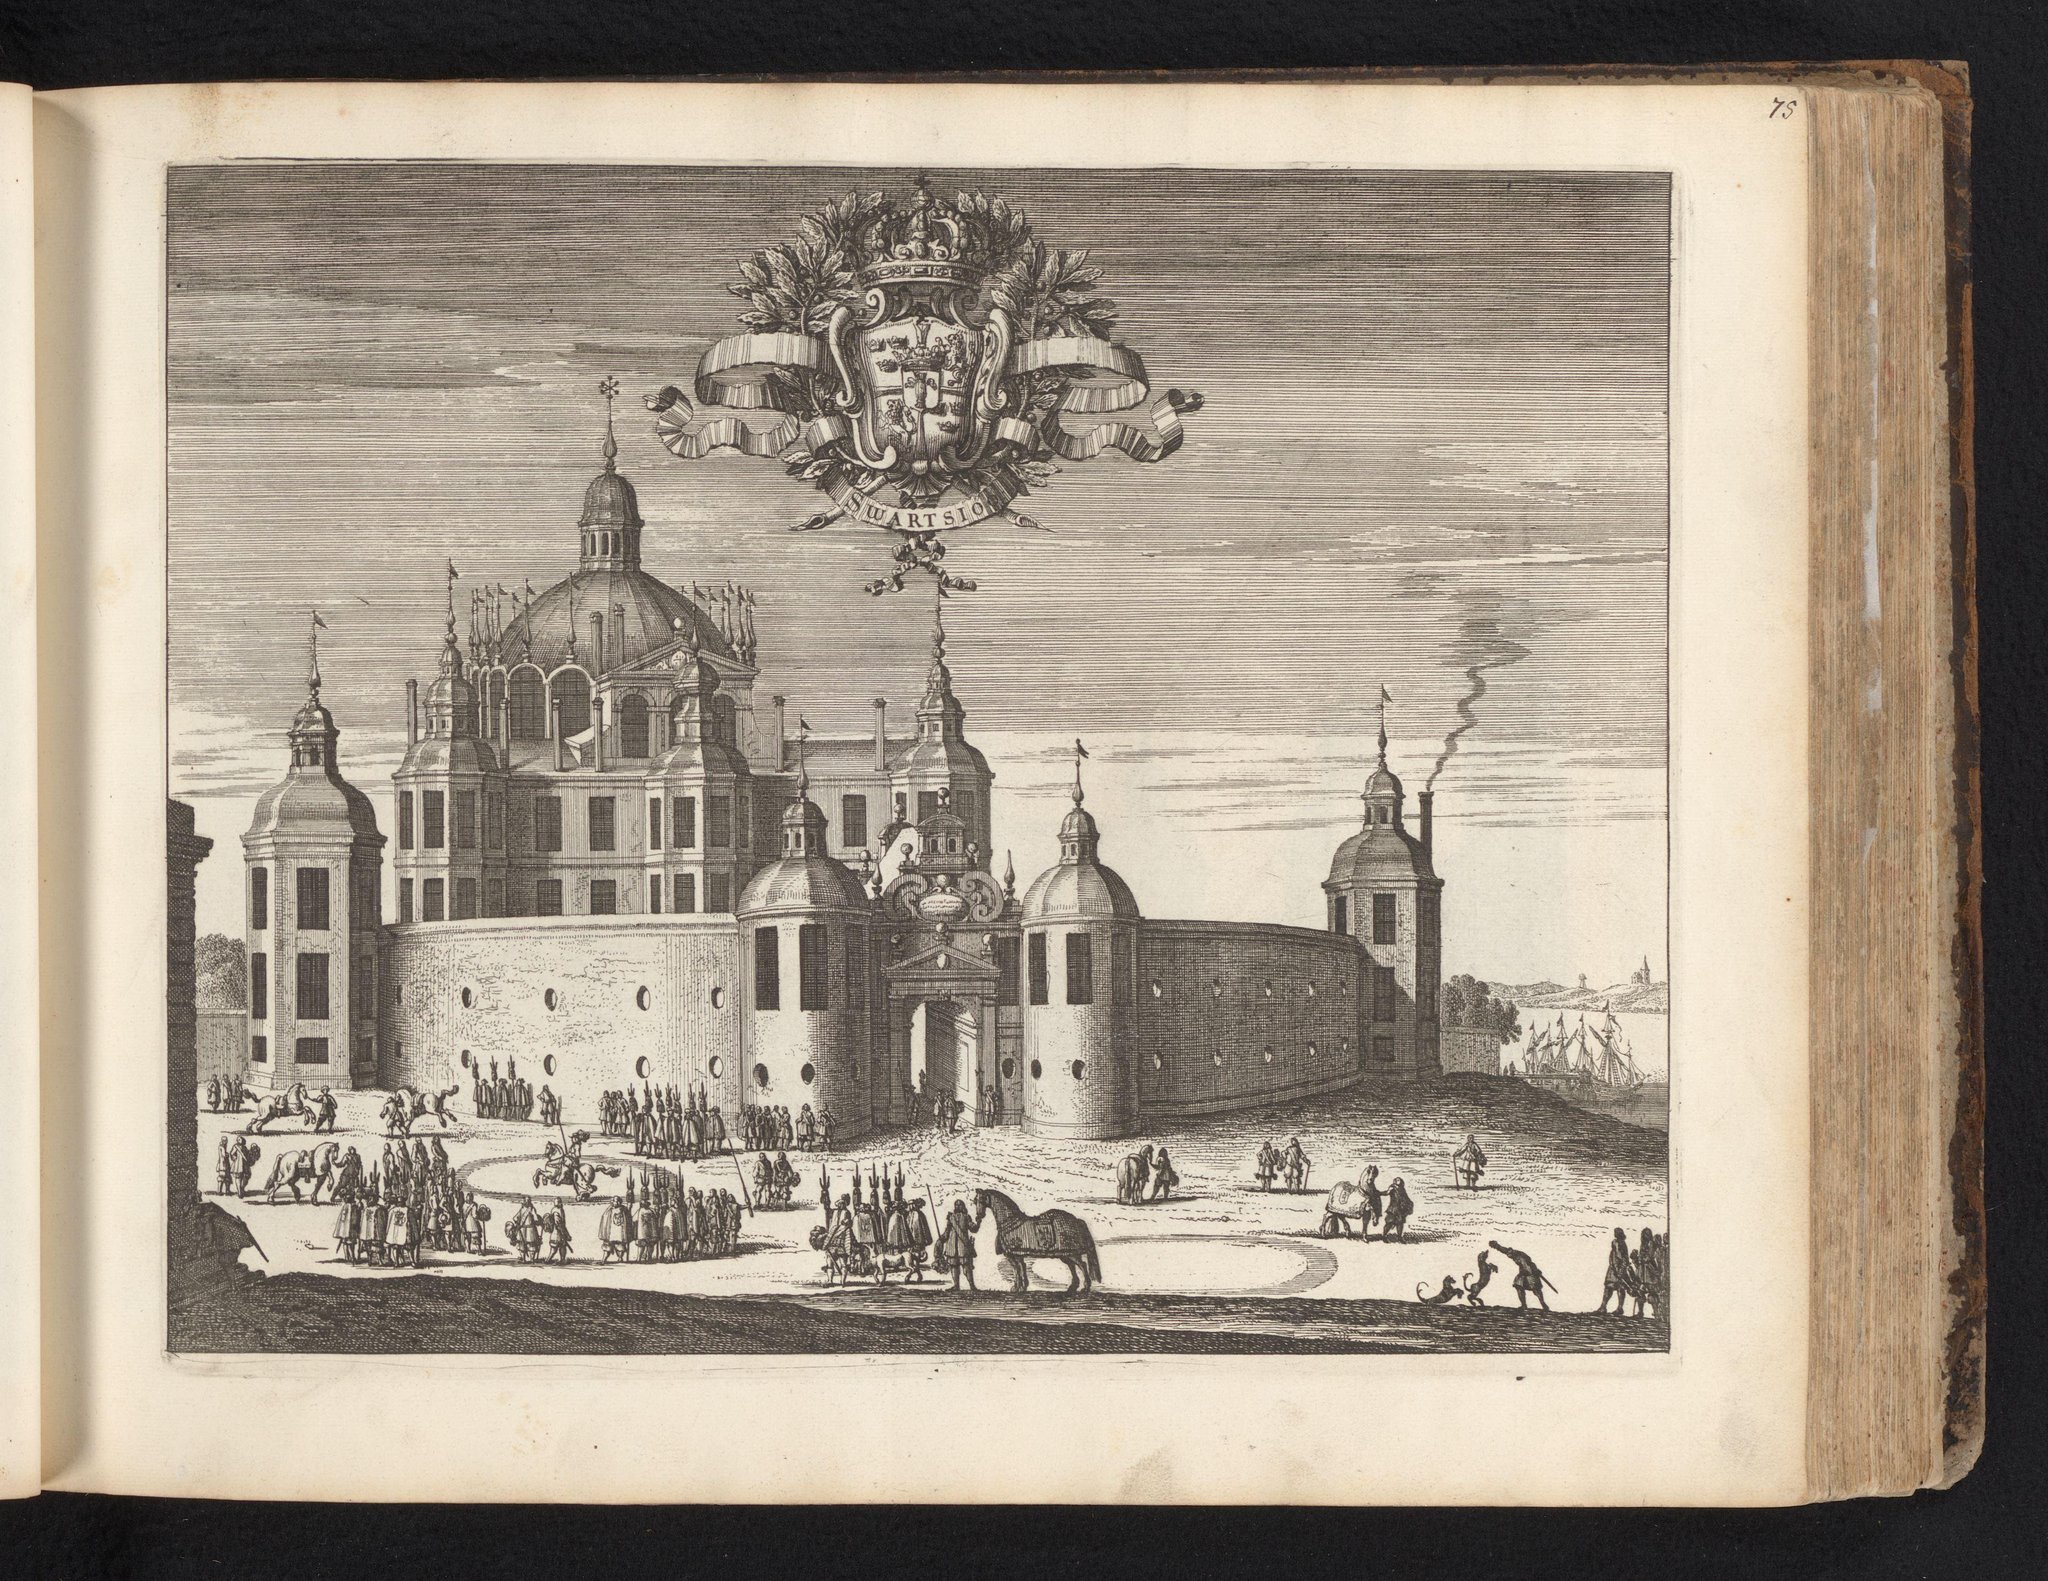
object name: album leaf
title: Paleis van Svartsjö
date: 1669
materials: paper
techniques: etching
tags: palace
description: Kungliga Biblioteket, 'Suecia': http://www.kb.se/samlingarna/Kartor-bilder/Suecia-antiqua/ (geraadpleegd november 2016).